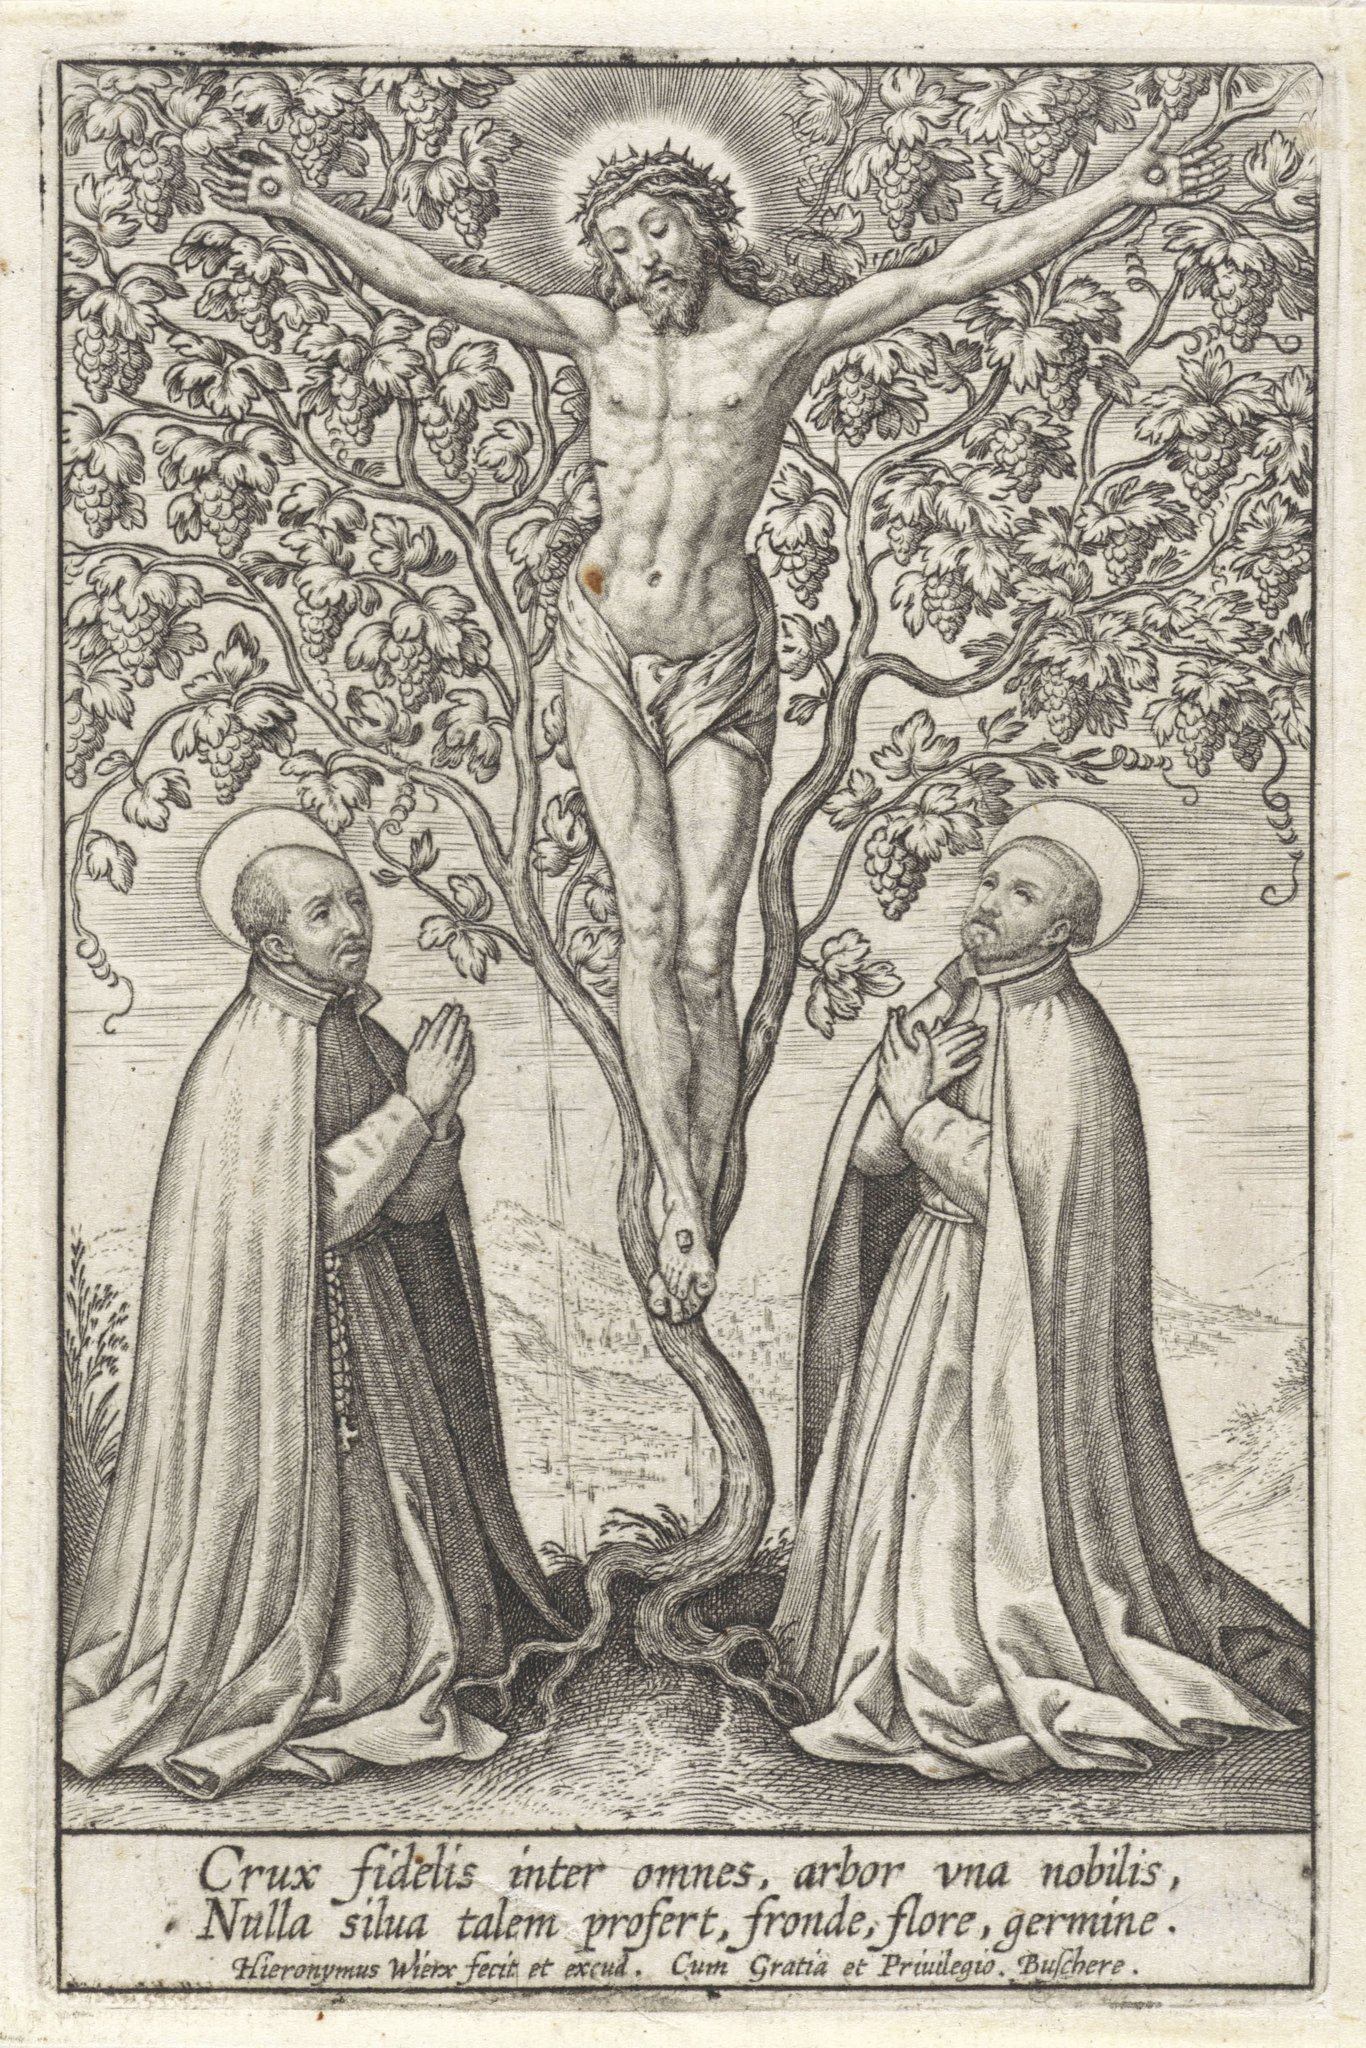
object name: print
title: Christus aan het kruis, aanbeden door Ignatius van Loyola en Franciscus Xaverius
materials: paper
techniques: engraving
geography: antwerp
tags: christ crucified on a tree or on a vine, the founder of the jesuit order, ignatius of loyola; possible attributes: book (with 'ad majorem dei gloriam'), demon, dragon under feet, flames, flaming heart, globe, ihs monogram, skull (with crown), tears in eyes, torch, the jesuit missionary francis xavier; possible attributes: cross, crucifix, flaming heart, indian, lily, torch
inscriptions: collector's mark: Lugt 2542, collector's mark: Lugt 2228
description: Christus is gekruisigd aan een levende wijnrank vol met druiven. Aan de voet van de boom knielen de jezuïeten Ignatius van Loyola (links) en Franciscus Xaverius (rechts) in aanbidding. In de marge een tweeregelig onderschrift in het Latijn.